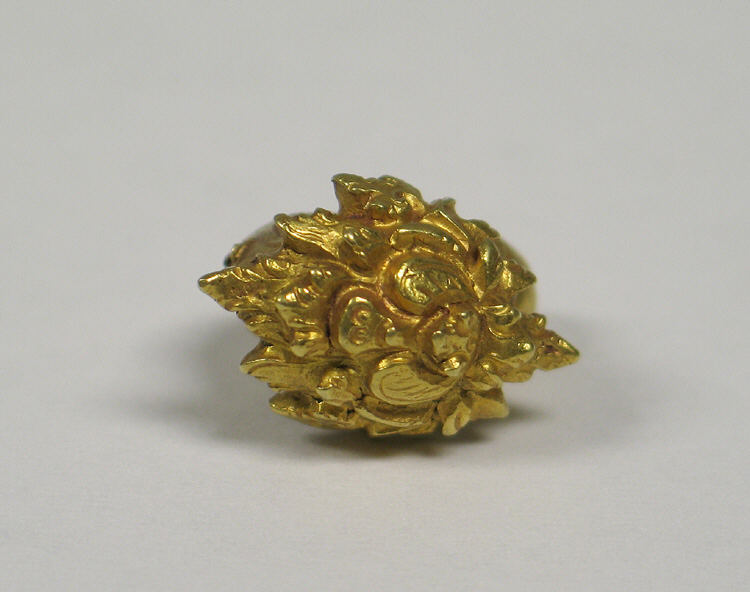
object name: ear ornament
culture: indonesian, central java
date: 701-1200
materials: gold